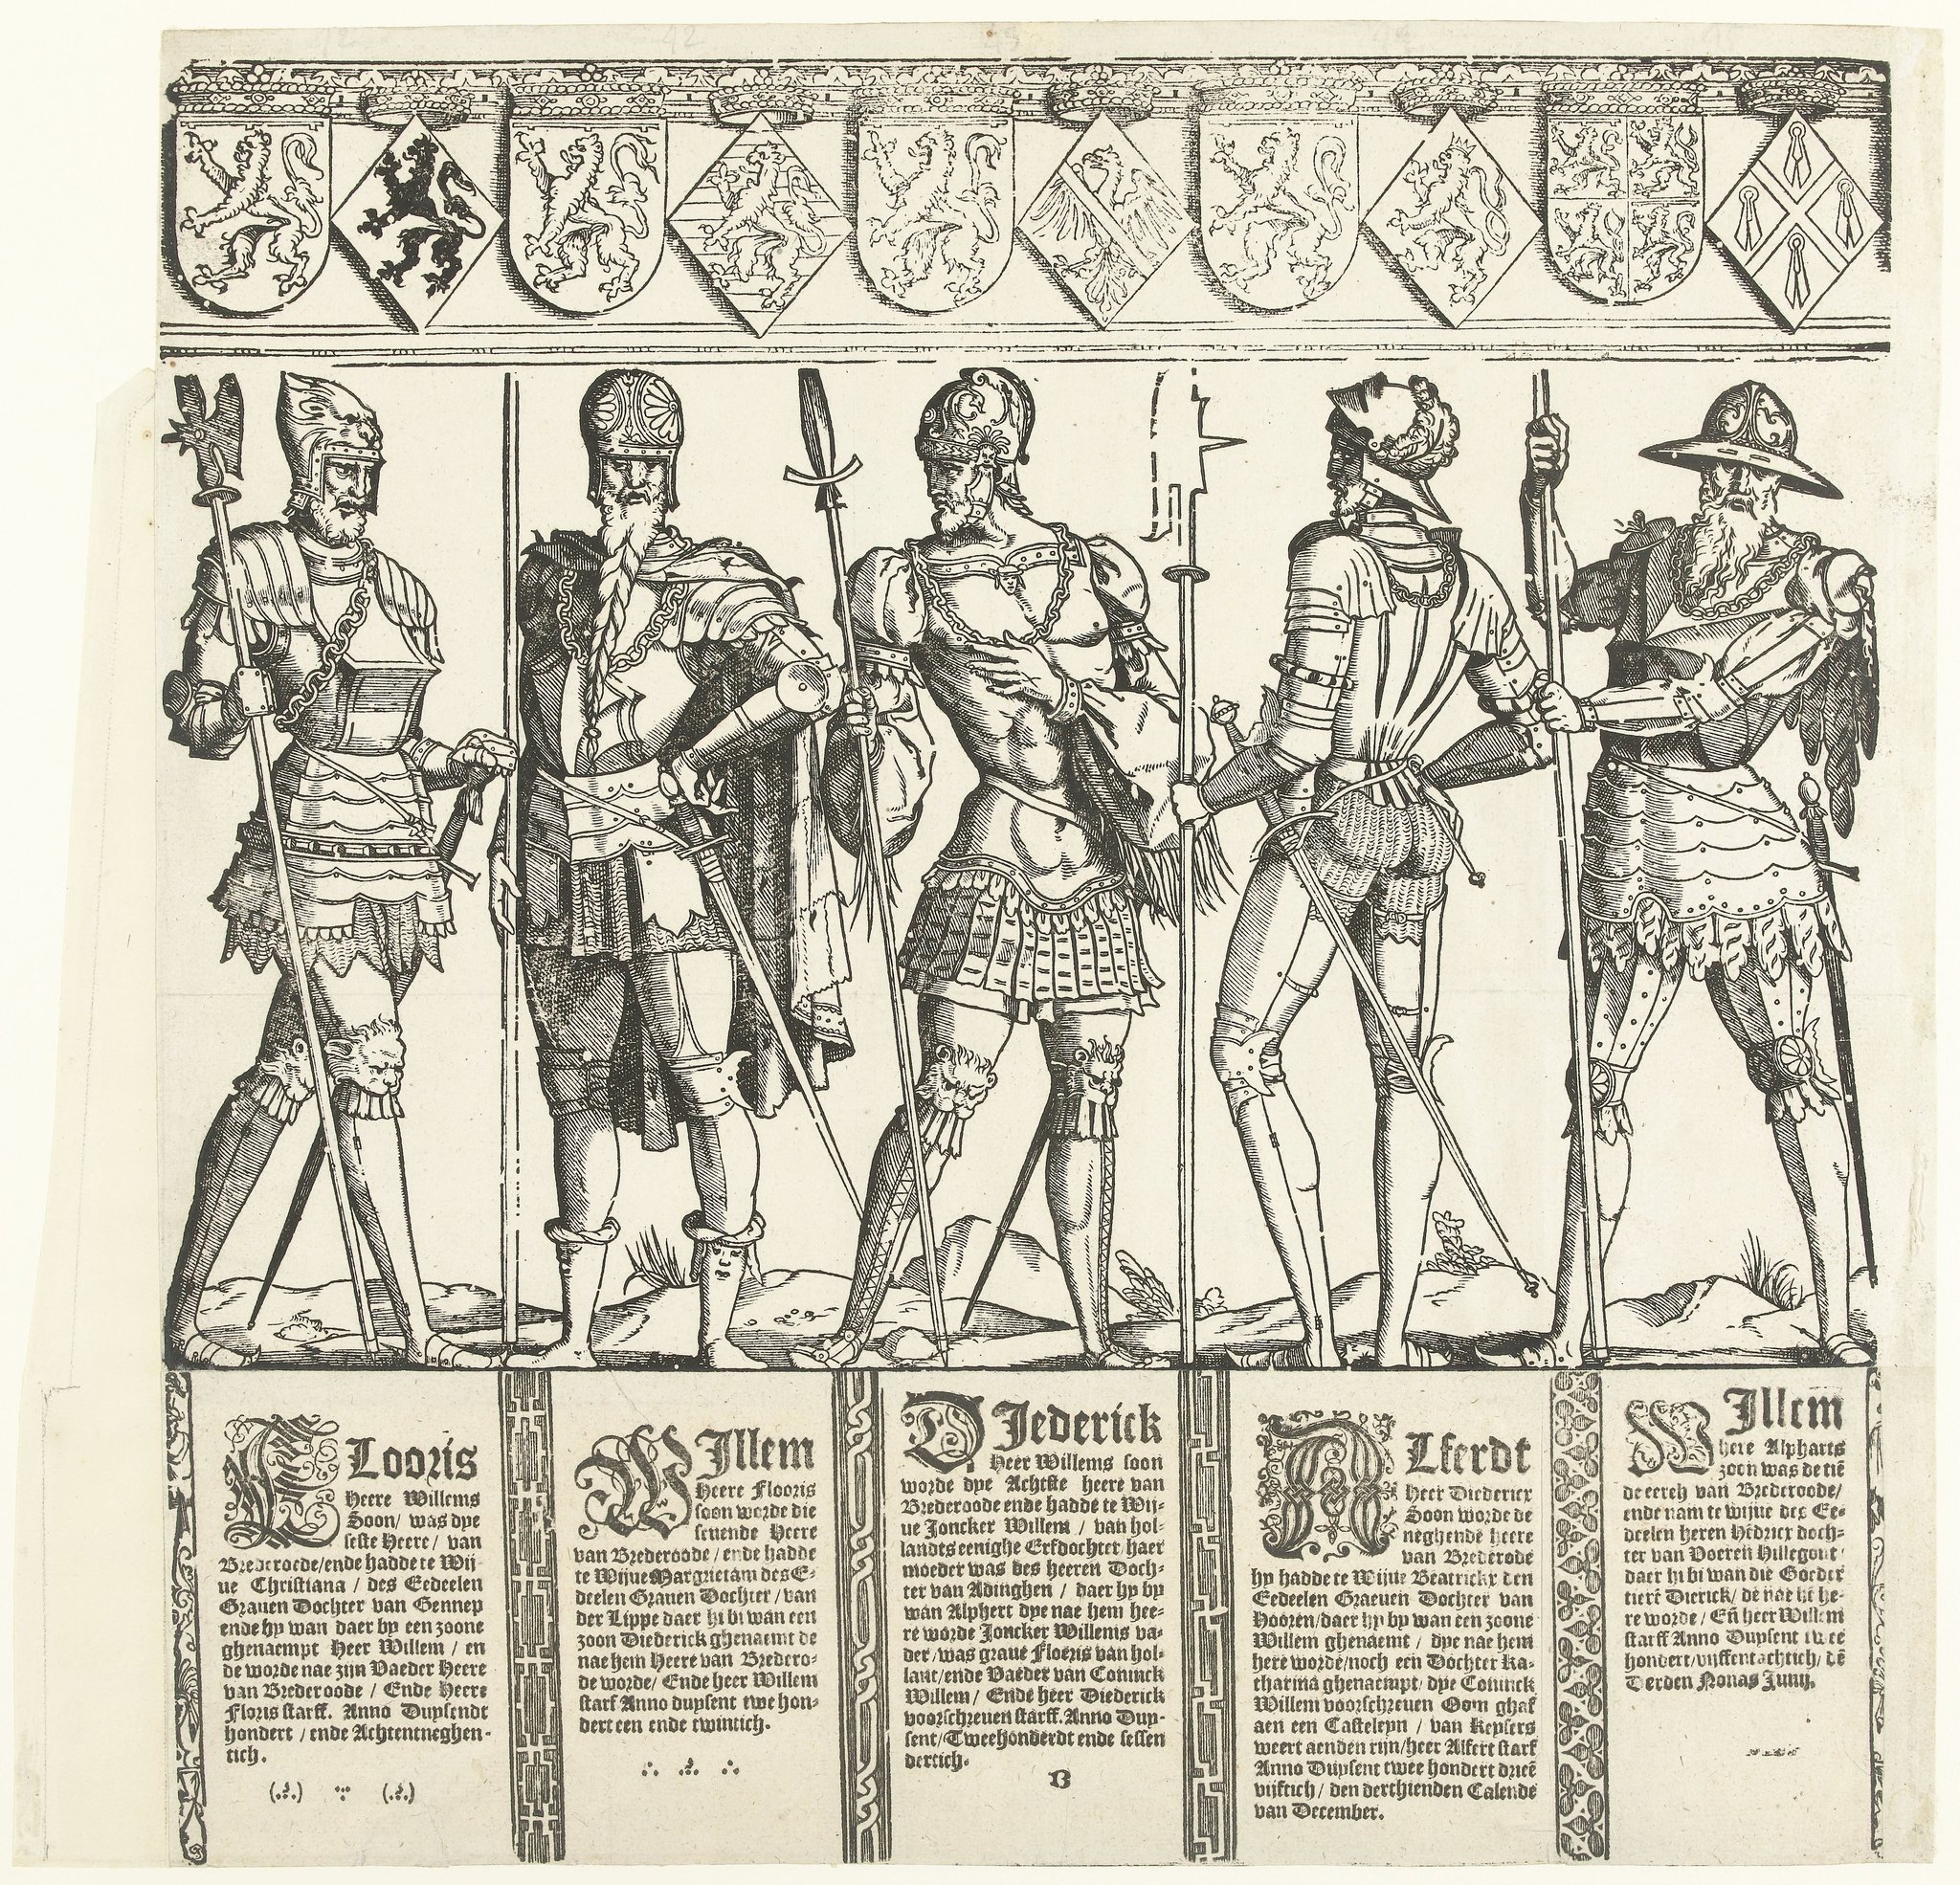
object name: print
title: Heren van Brederode, van Zyphridus tot en met Reinout III (linker middenblad)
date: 1550-1551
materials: paper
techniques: letterpress printing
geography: amsterdam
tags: historical persons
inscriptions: collector's mark: Lugt 2228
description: Linker middenblad van een fries op vier losse bladen met twintig Heren van Brederode, van Zyphridus tot en met Reinout III. Vijf portretten van verschillende Heren van Brederode in wapenrusting. In de bovenmarge hun wapens en de wapens van hun vrouwen. In de ondermarge hun namen en vijf kolommen met Nederlandse tekst in boekdruk over hun levens.